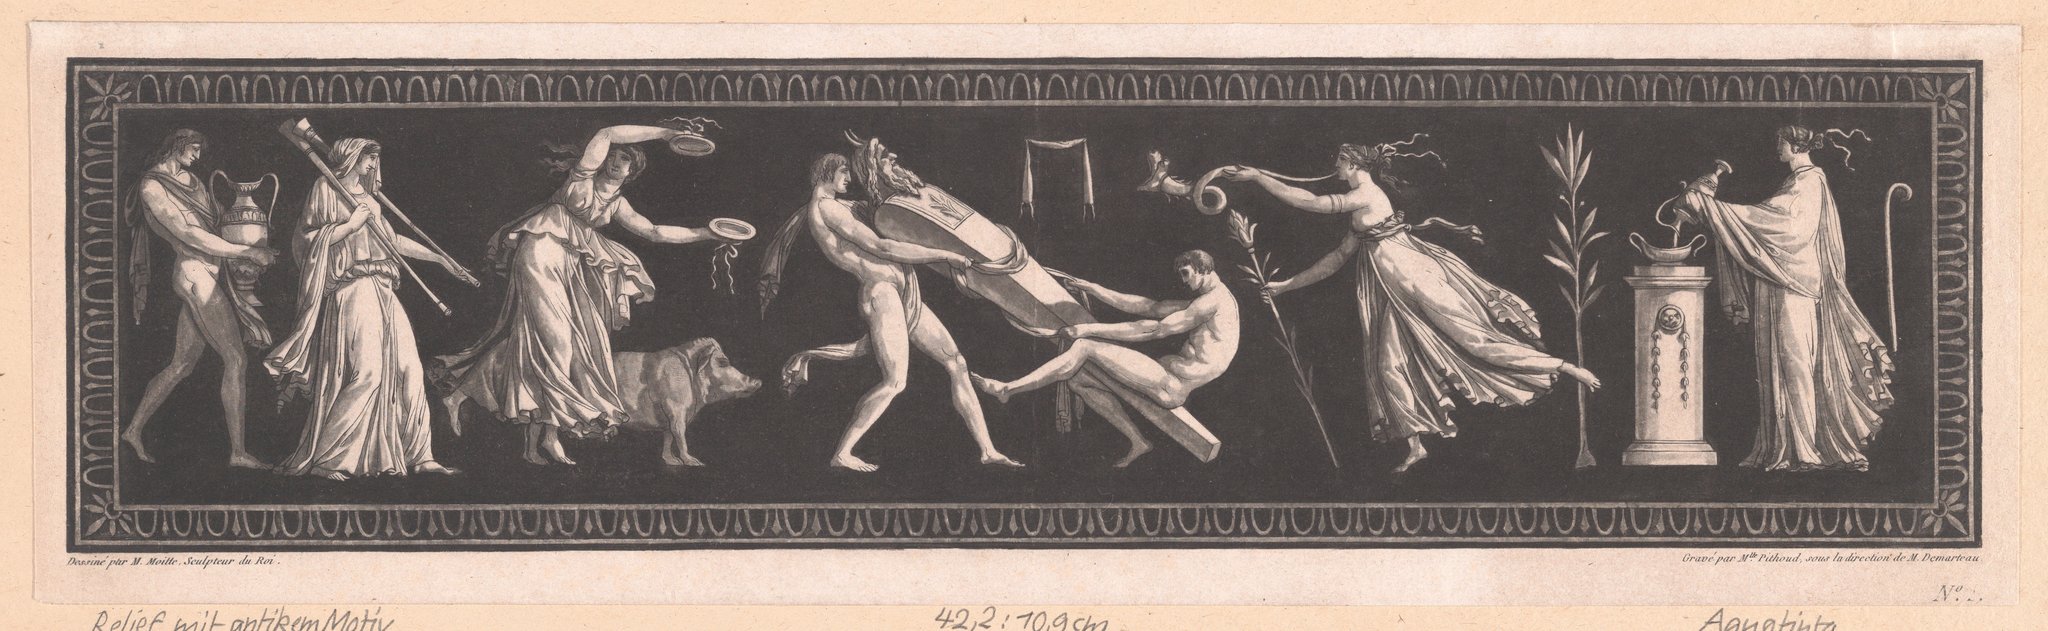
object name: print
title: Frieze with Antique Motifs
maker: louise pithoud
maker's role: artist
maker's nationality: french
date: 1791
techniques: aquatint, printmaking, engraving, etching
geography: germany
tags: men,women,boars